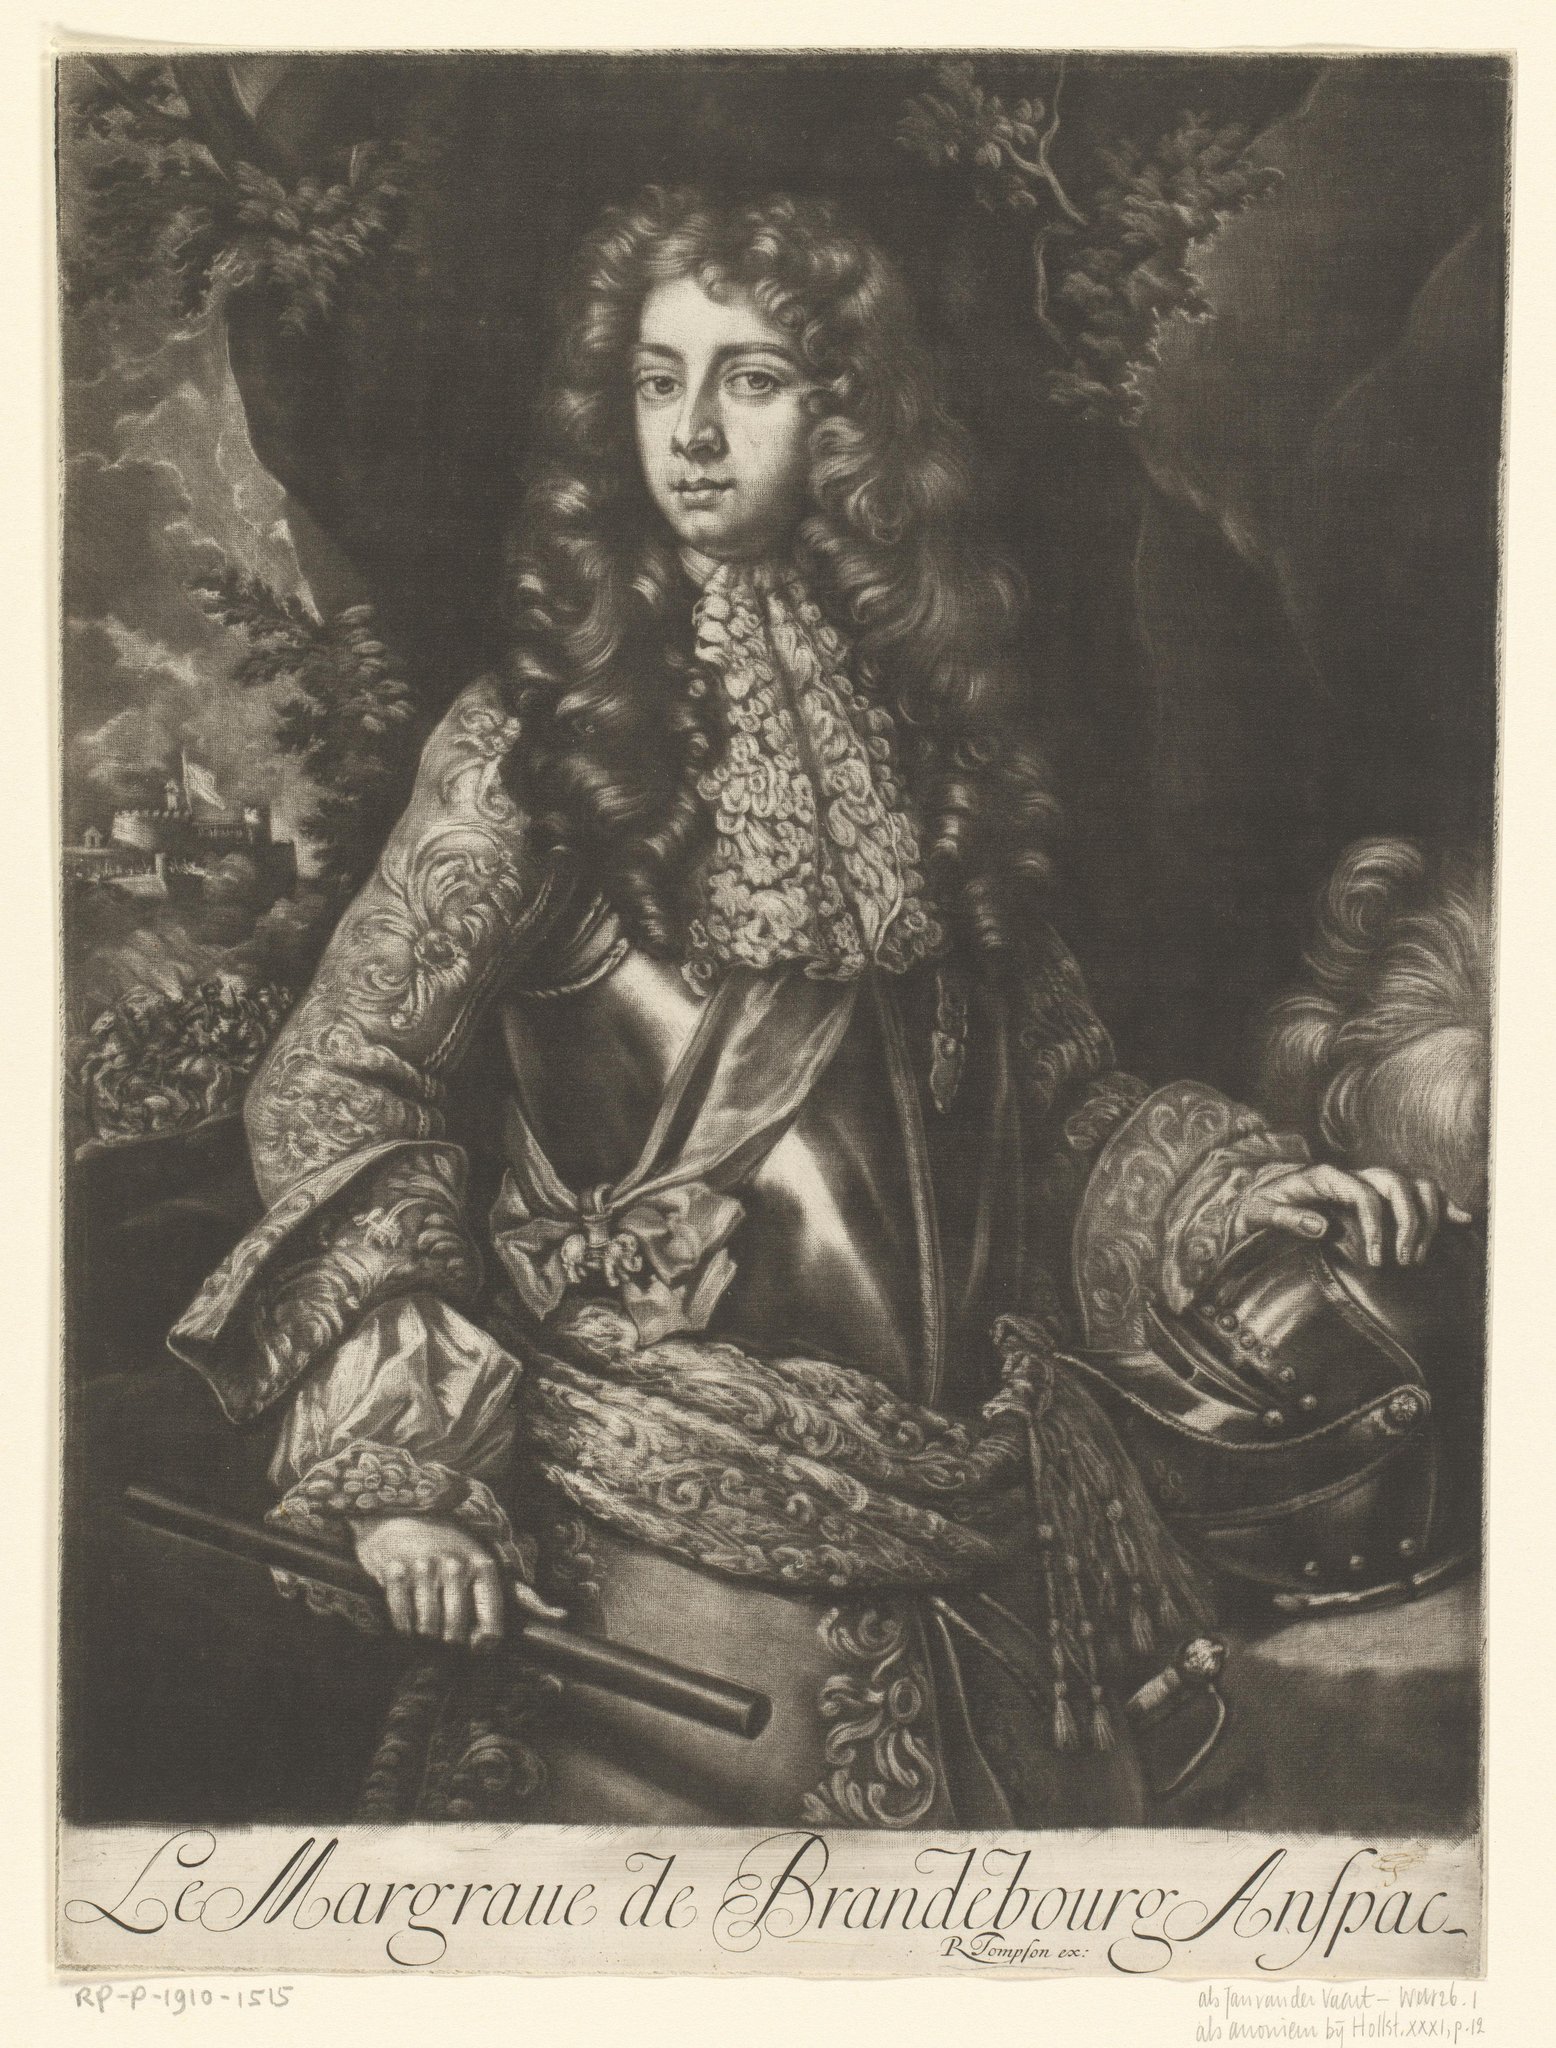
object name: print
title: Portret van Johan Frederik van Brandenburg-Ansbach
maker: richard tompson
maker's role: print maker, publisher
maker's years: -1693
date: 1678-1680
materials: paper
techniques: mezzotint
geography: london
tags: historical persons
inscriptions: collector's mark: Lugt 2228